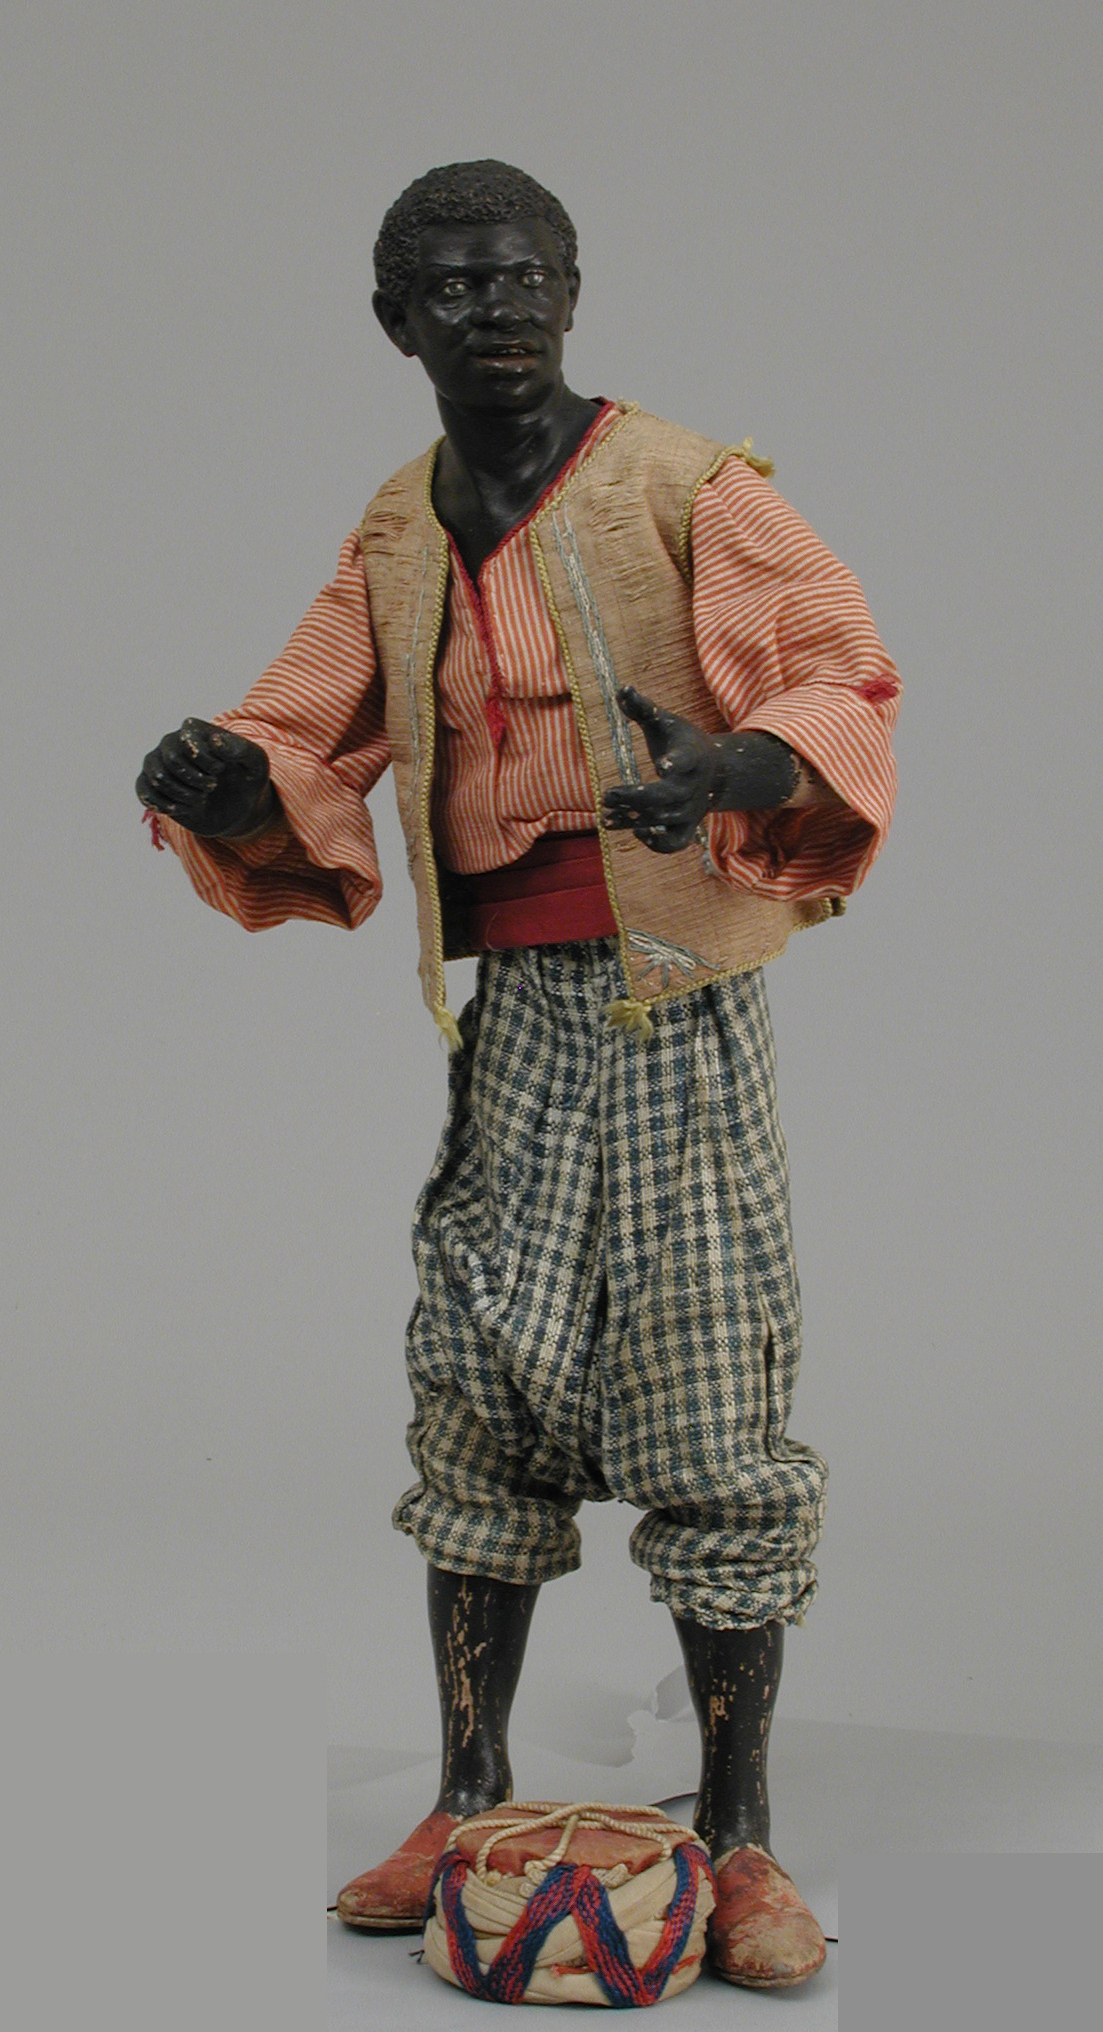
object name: crèche figure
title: Moorish attendant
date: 1751-1800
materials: linen, silk, terracotta, fiber, metal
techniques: polychrome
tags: men